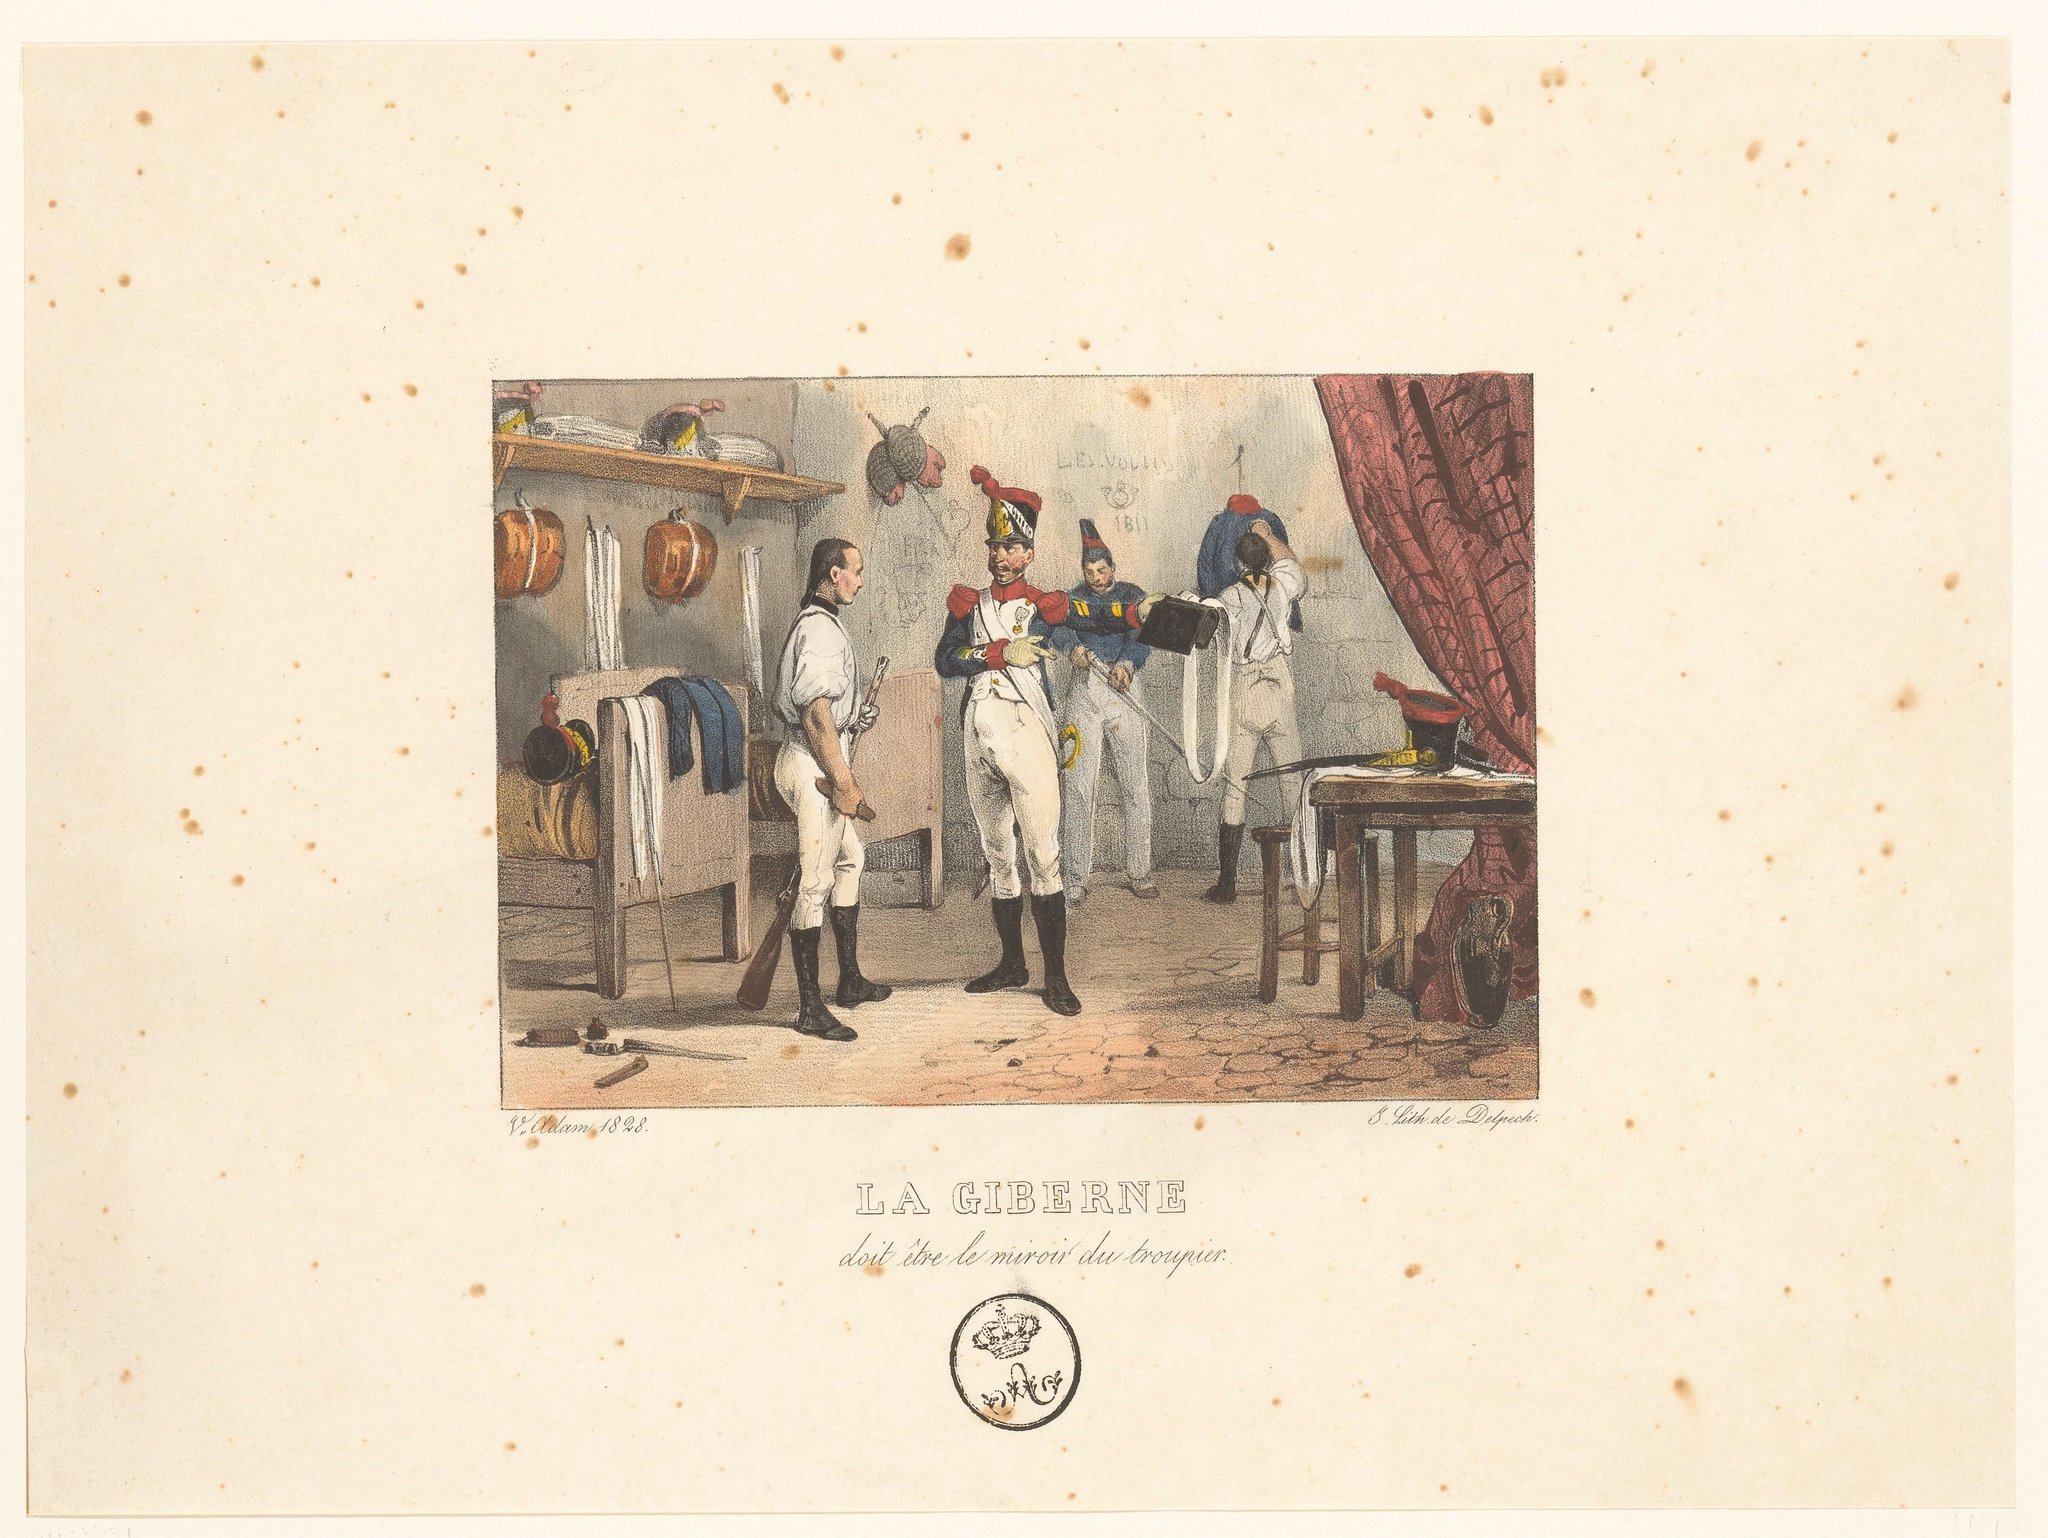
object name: print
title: Officier met patroontas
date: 1828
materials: paper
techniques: hand coloring, lithograph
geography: paris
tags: the soldier; the soldier's life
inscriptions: collector's mark: Lugt 2228, stamp: ‘A’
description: Een officier toont een soldaat zijn patroontas.